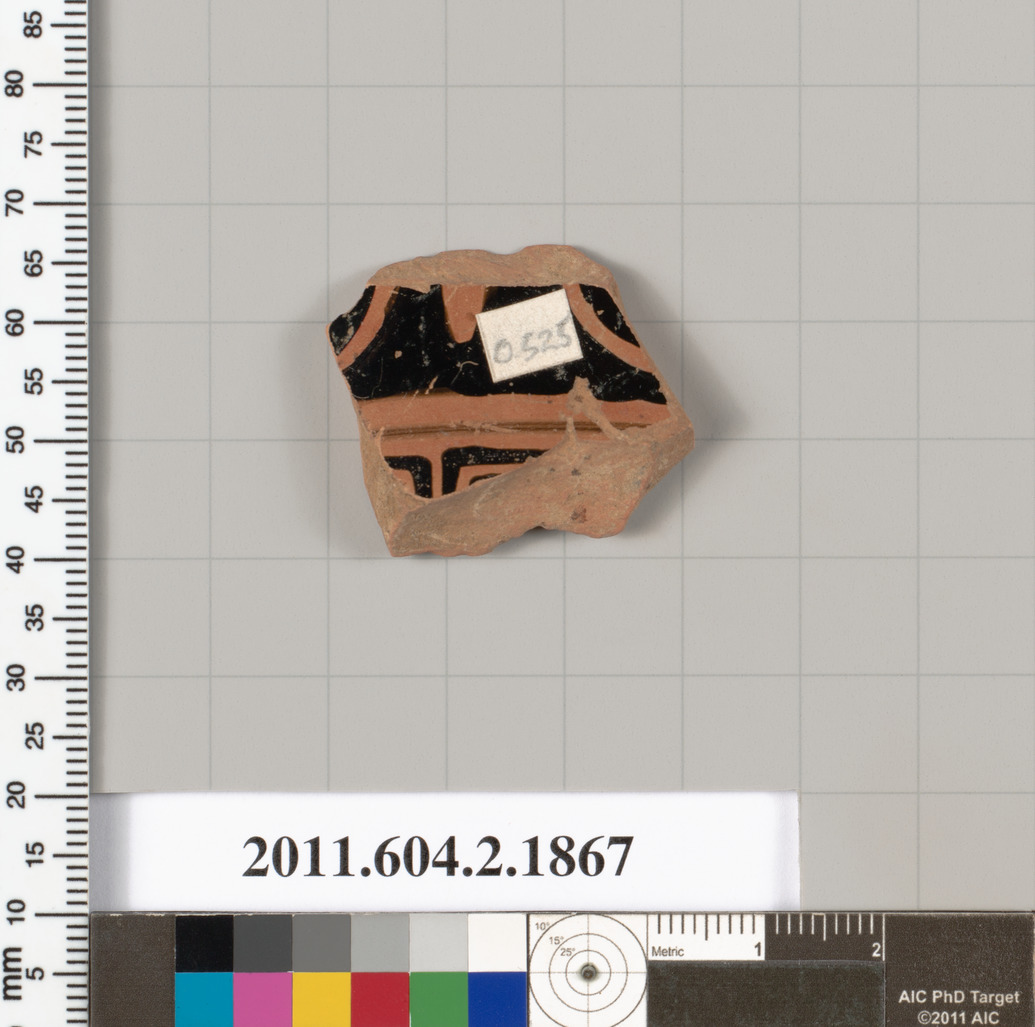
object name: skyphos fragment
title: Terracotta fragment of a skyphos (deep drinking cup)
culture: greek, attic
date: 450-426 BCE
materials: terracotta